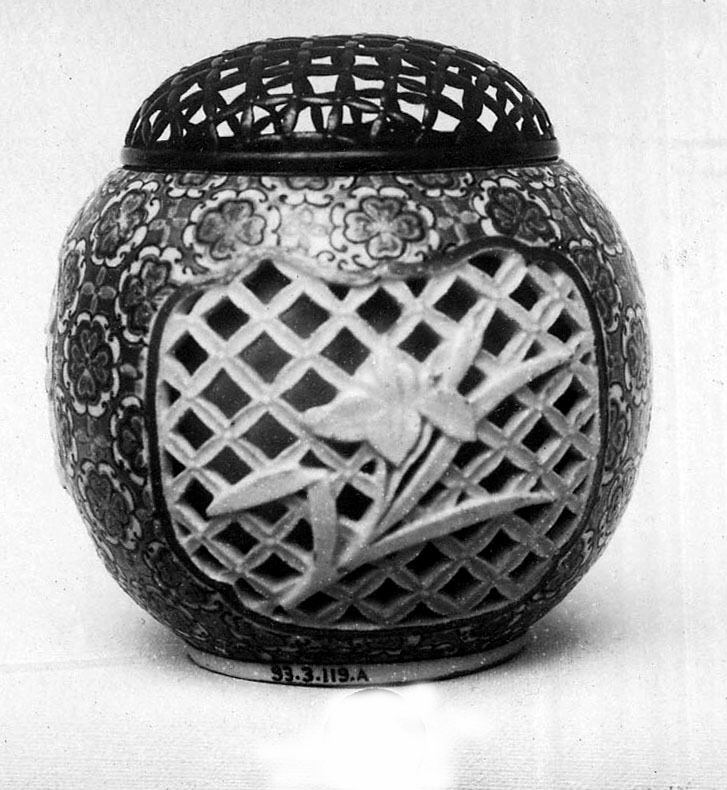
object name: incense burner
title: Incense Burner with Openwork Panels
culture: japanese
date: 1820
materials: clay, enamel, glaze, gold